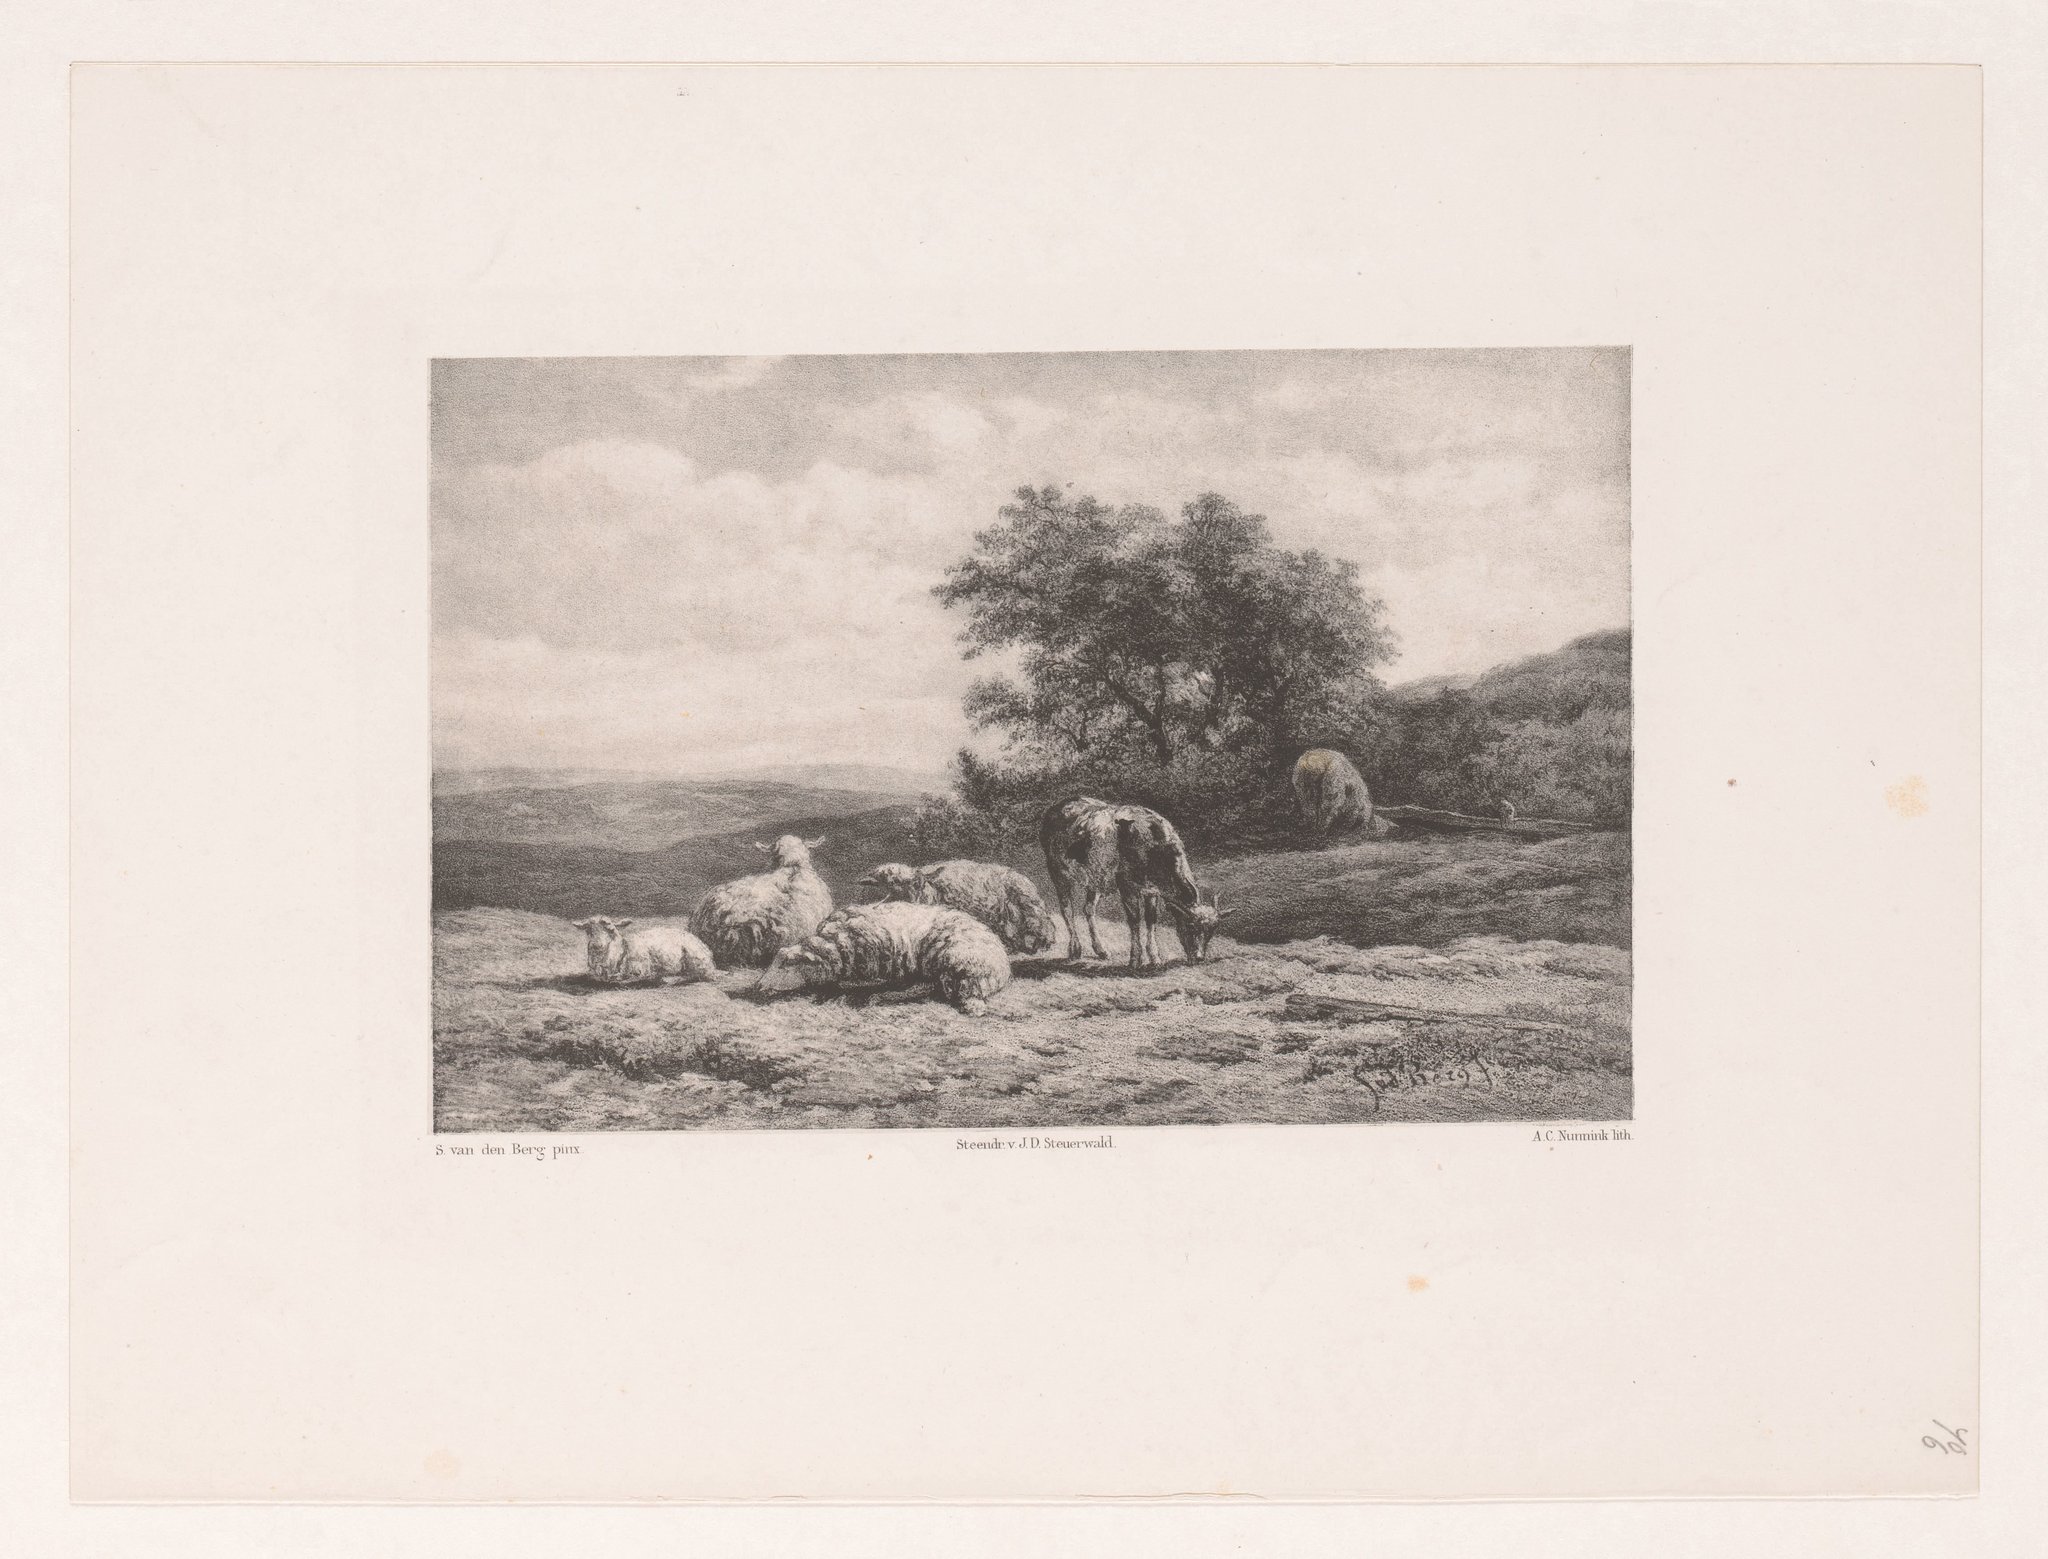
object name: print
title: Bok en schapen in landschap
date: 1833-1863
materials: paper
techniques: lithograph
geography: the hague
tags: sheep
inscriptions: collector's mark: Lugt 2228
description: Liggende en grazende bok en vijf schapen in een heuvellandschap.